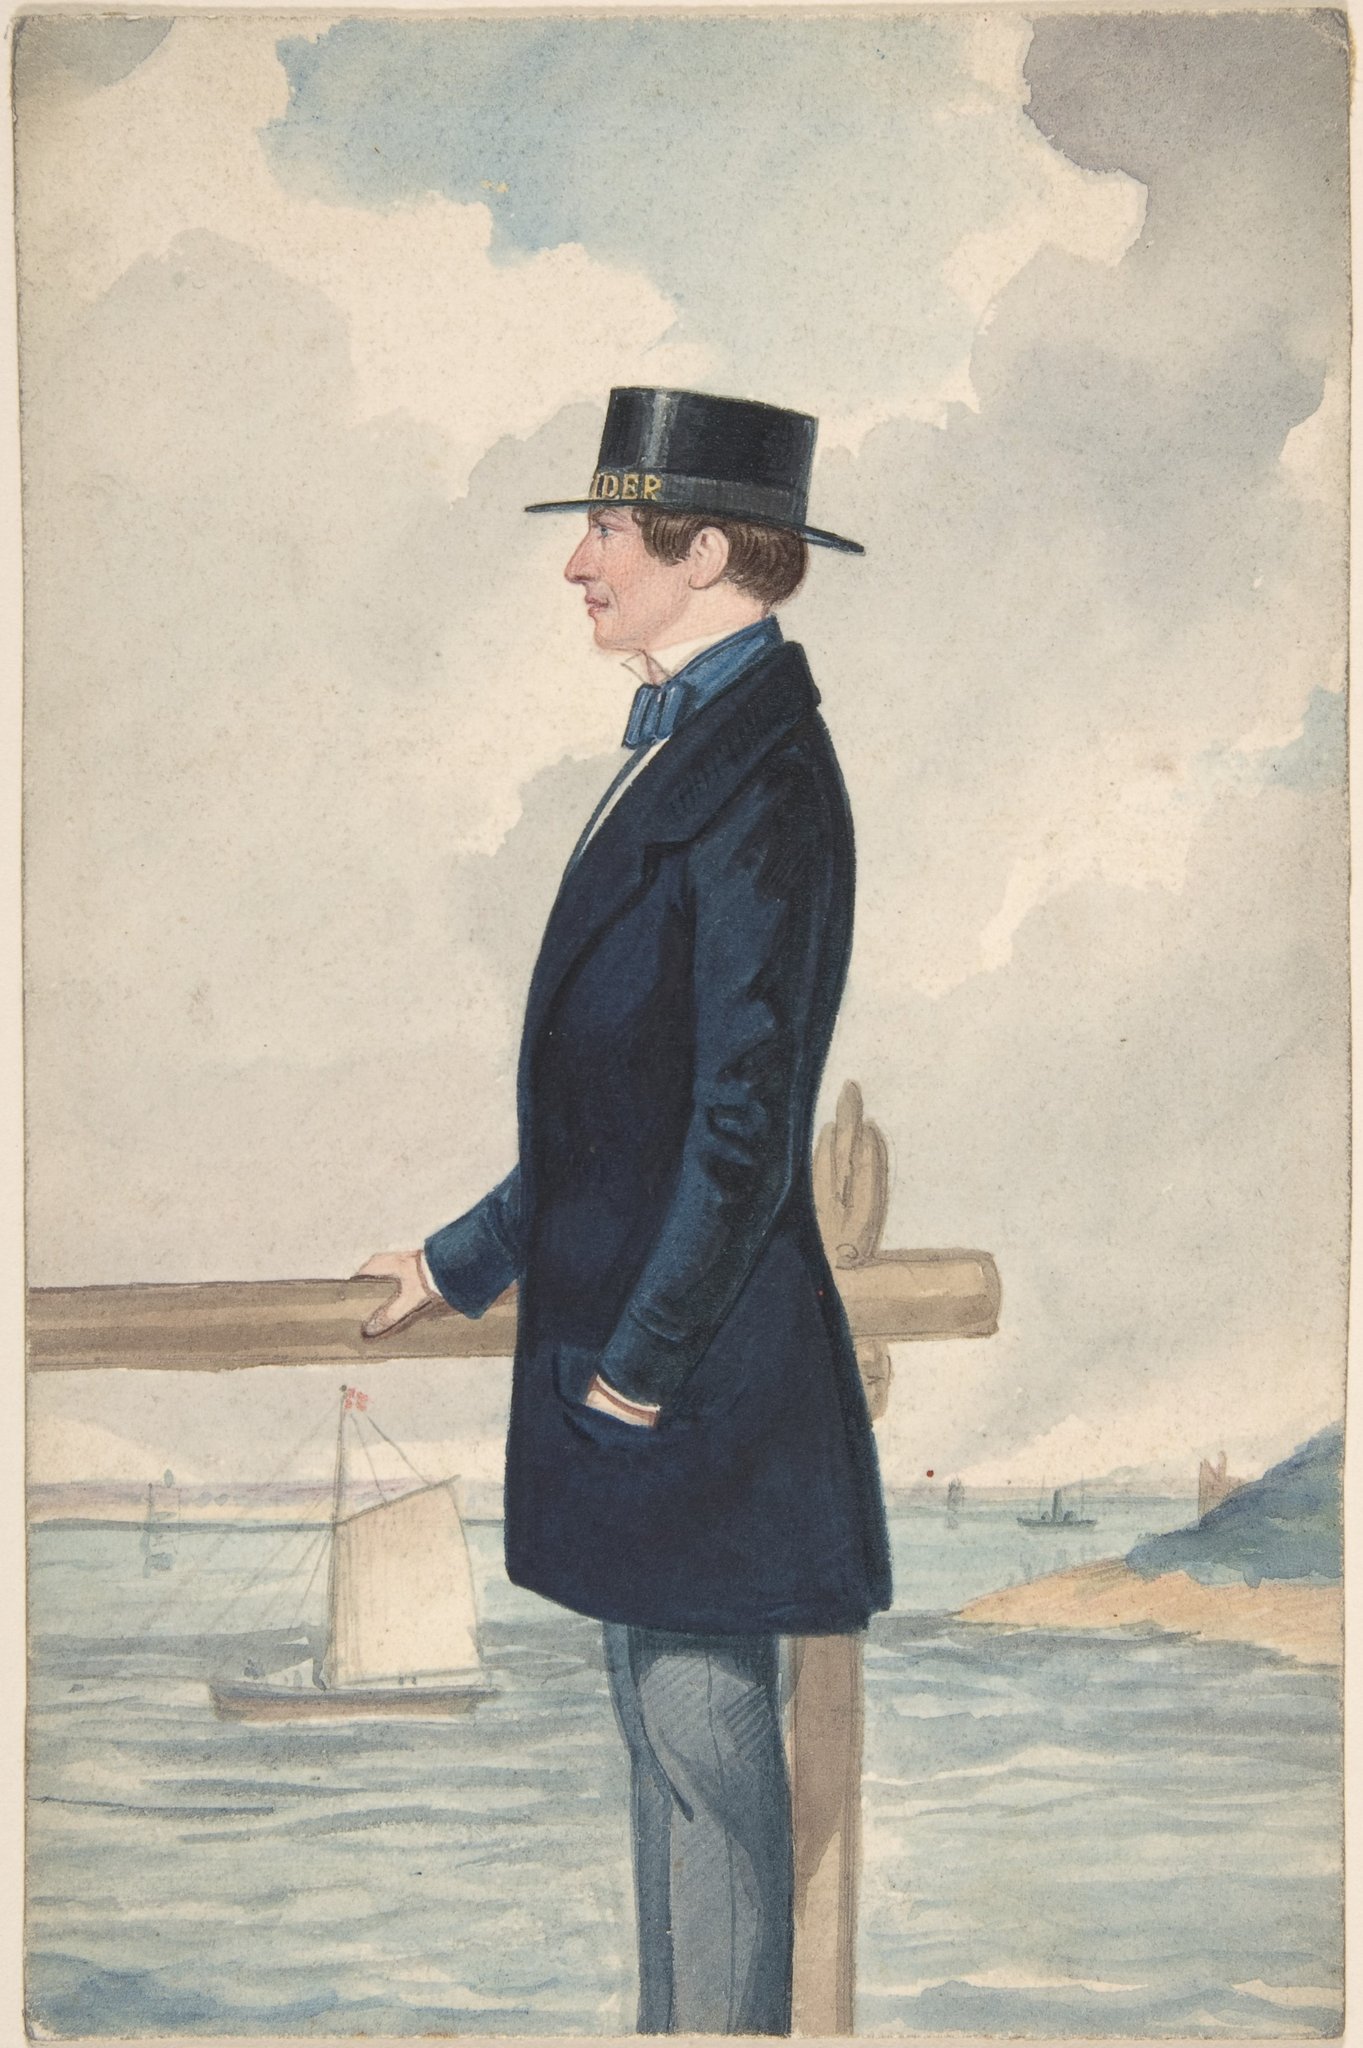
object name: drawing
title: A Yachtsman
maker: robert dighton, the younger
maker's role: artist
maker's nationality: british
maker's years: 1786-1865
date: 1806-1865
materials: graphite, watercolor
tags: men,profiles,boats